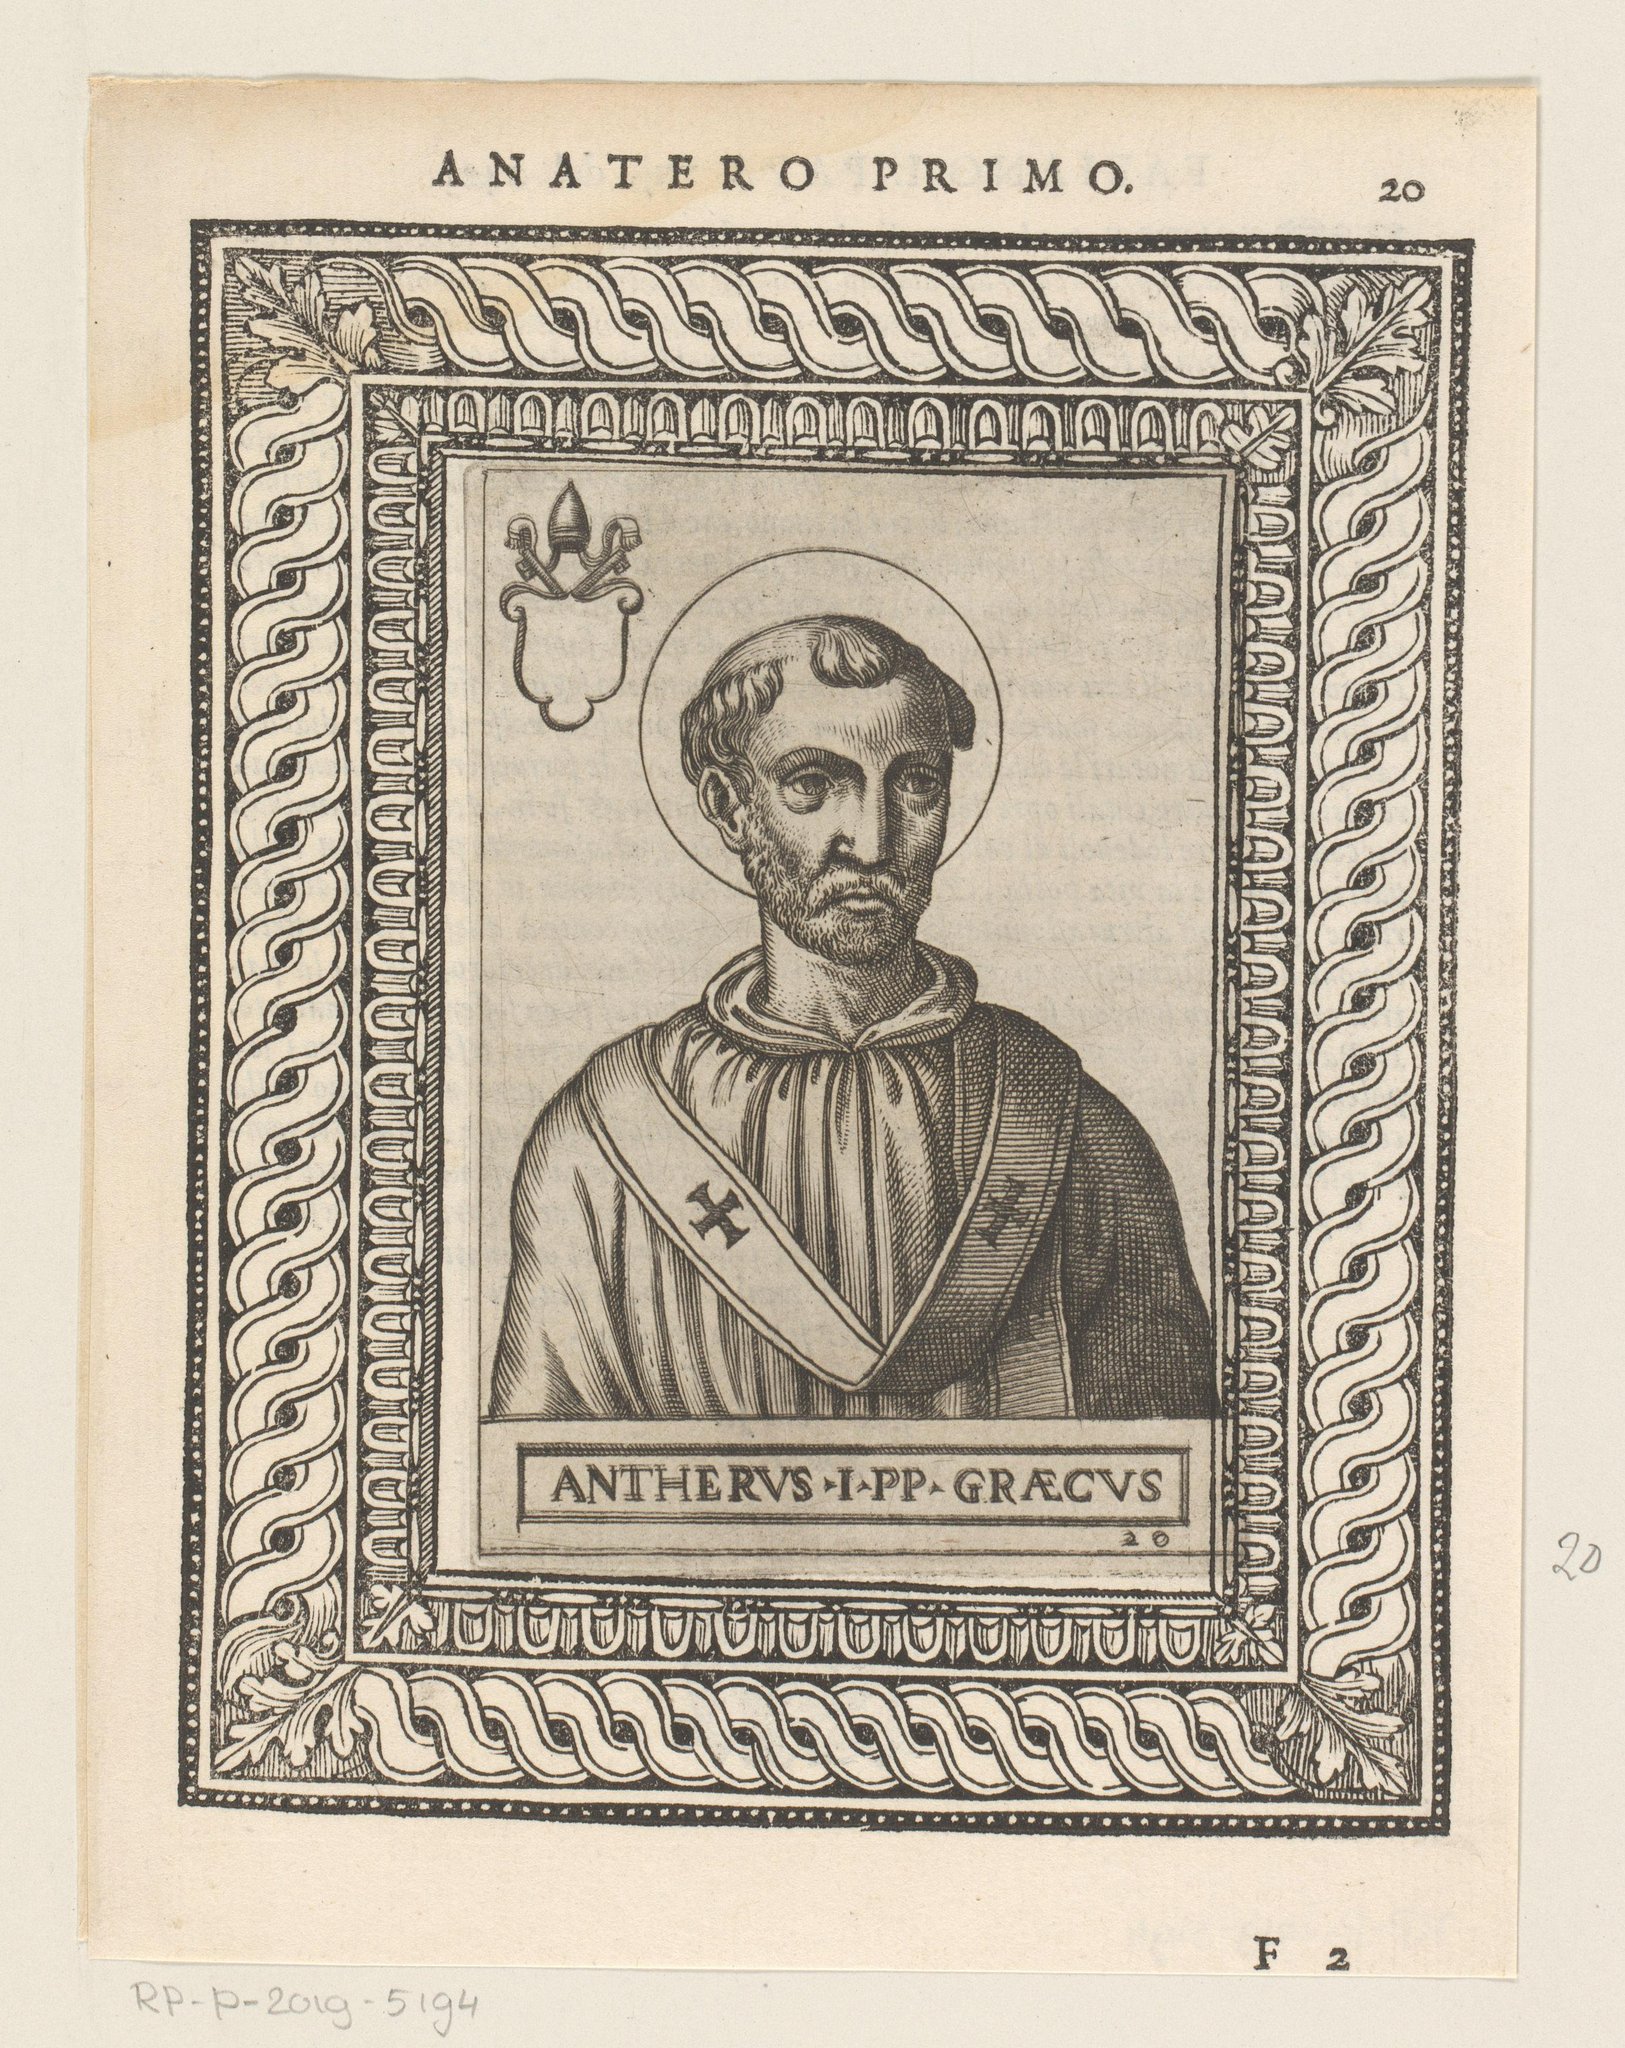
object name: book illustration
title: Antherus I PP Graecus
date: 1587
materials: paper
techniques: engraving, etching, letterpress printing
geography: rome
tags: calabria, historical persons, pope, armorial bearing, heraldry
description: Prent uit: Ciccarelli, Antonio. Le vite de Pontefici di Antonio Ciccareli (...). Rome: Dominicus Basa, 1588. Prent ook gebruikt in latere edities.